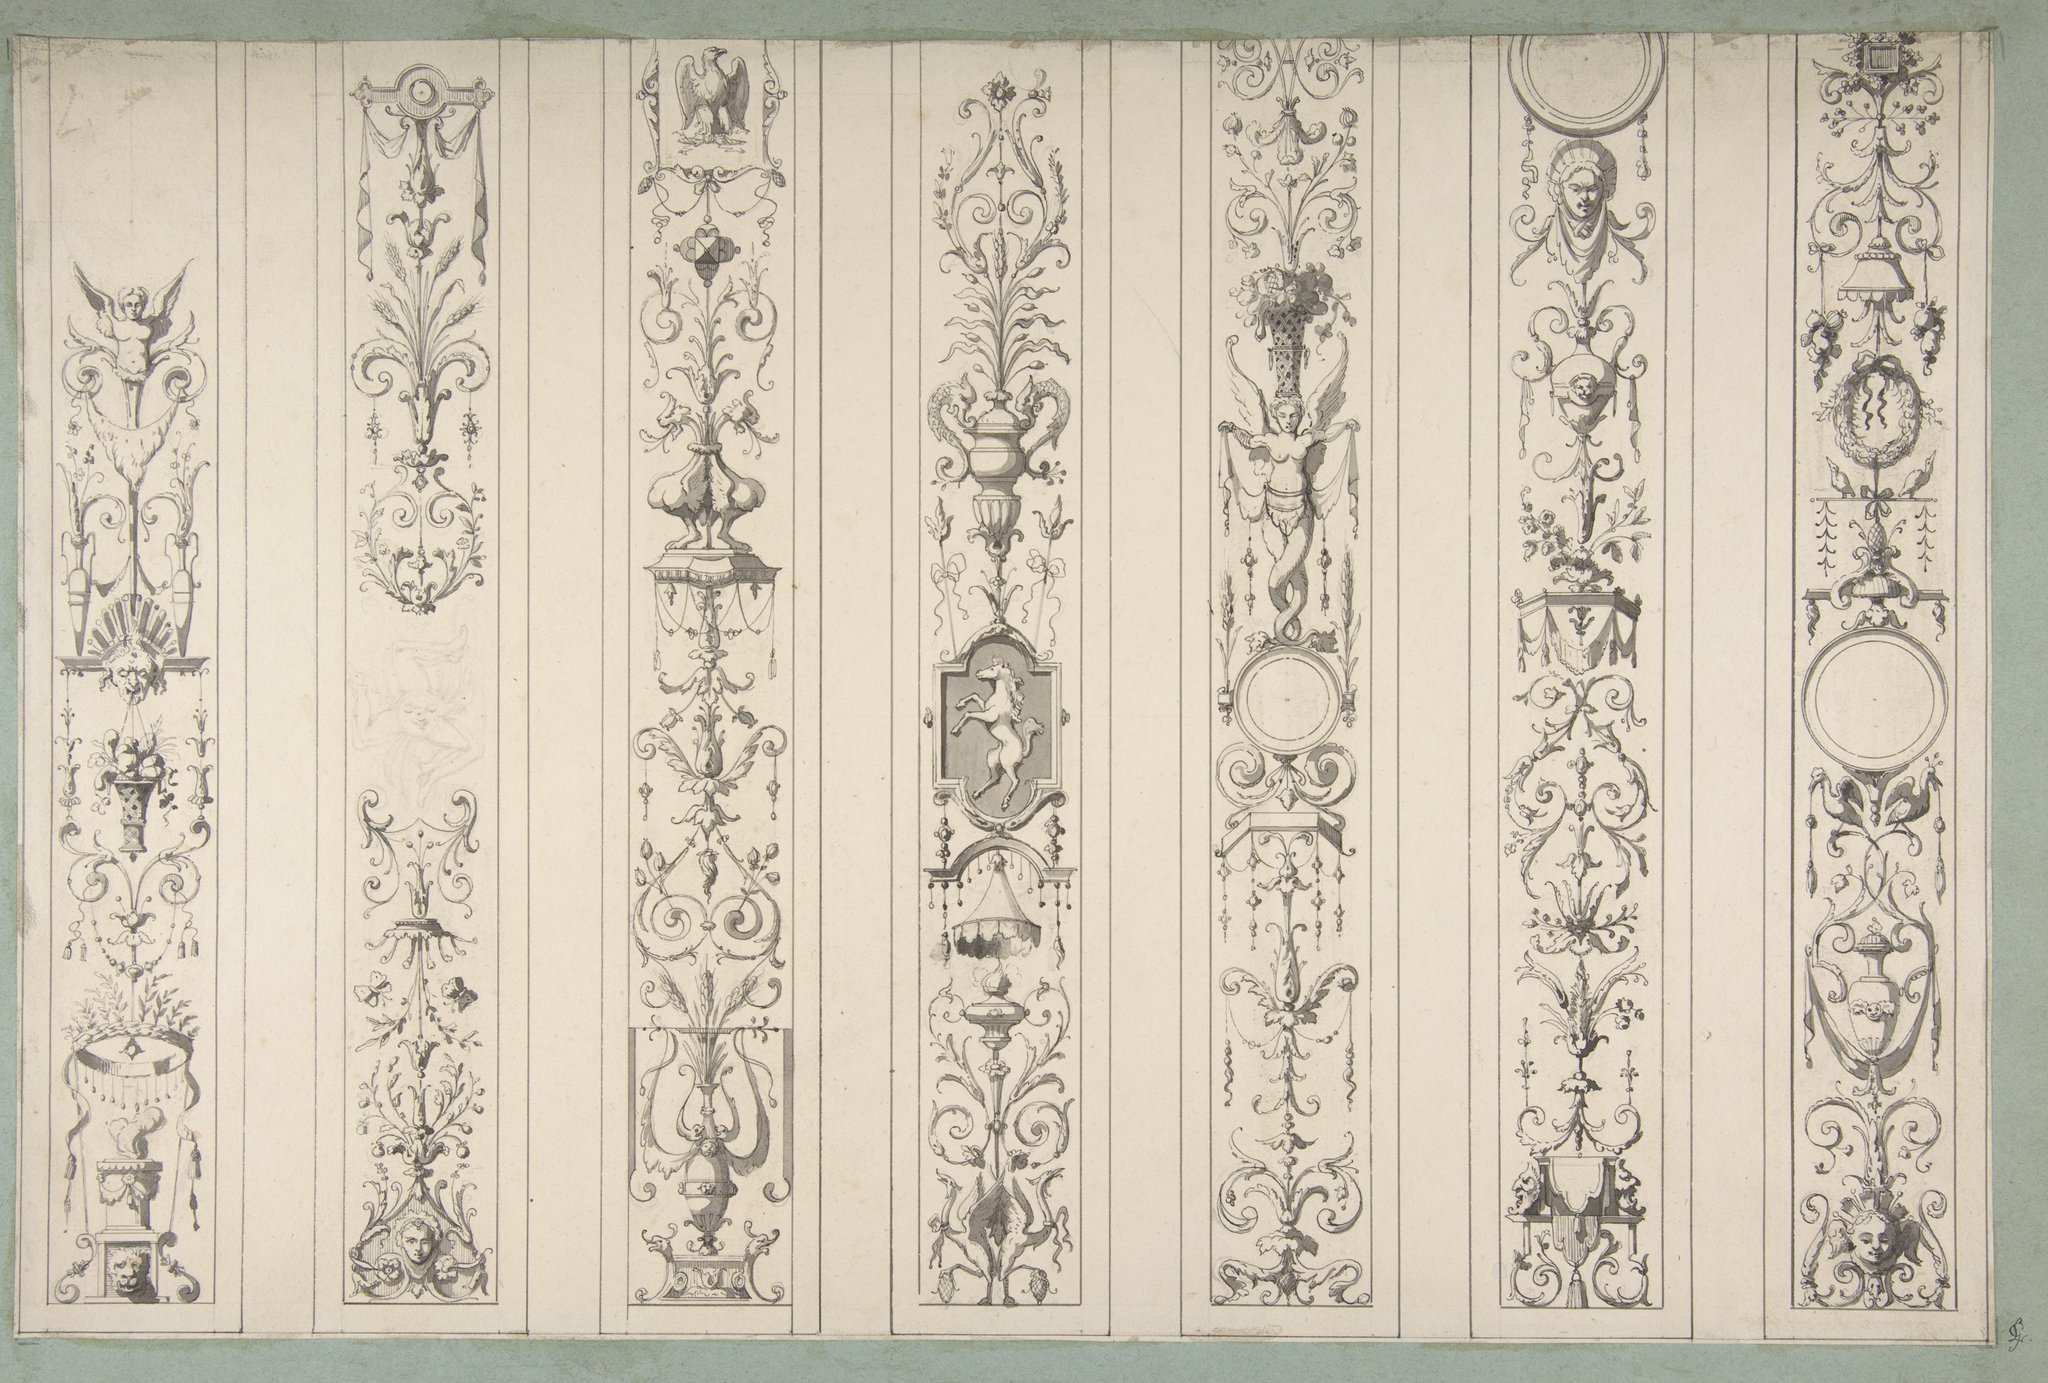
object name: drawing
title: Design for Seven Vertical Panels of Arabesque Decoration, Farnsborough, England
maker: jules-edmond-charles lachaise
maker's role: artist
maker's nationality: french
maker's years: 1897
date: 1880-1886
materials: graphite, ink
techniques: brush, pen, wash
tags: horses,coat of arms